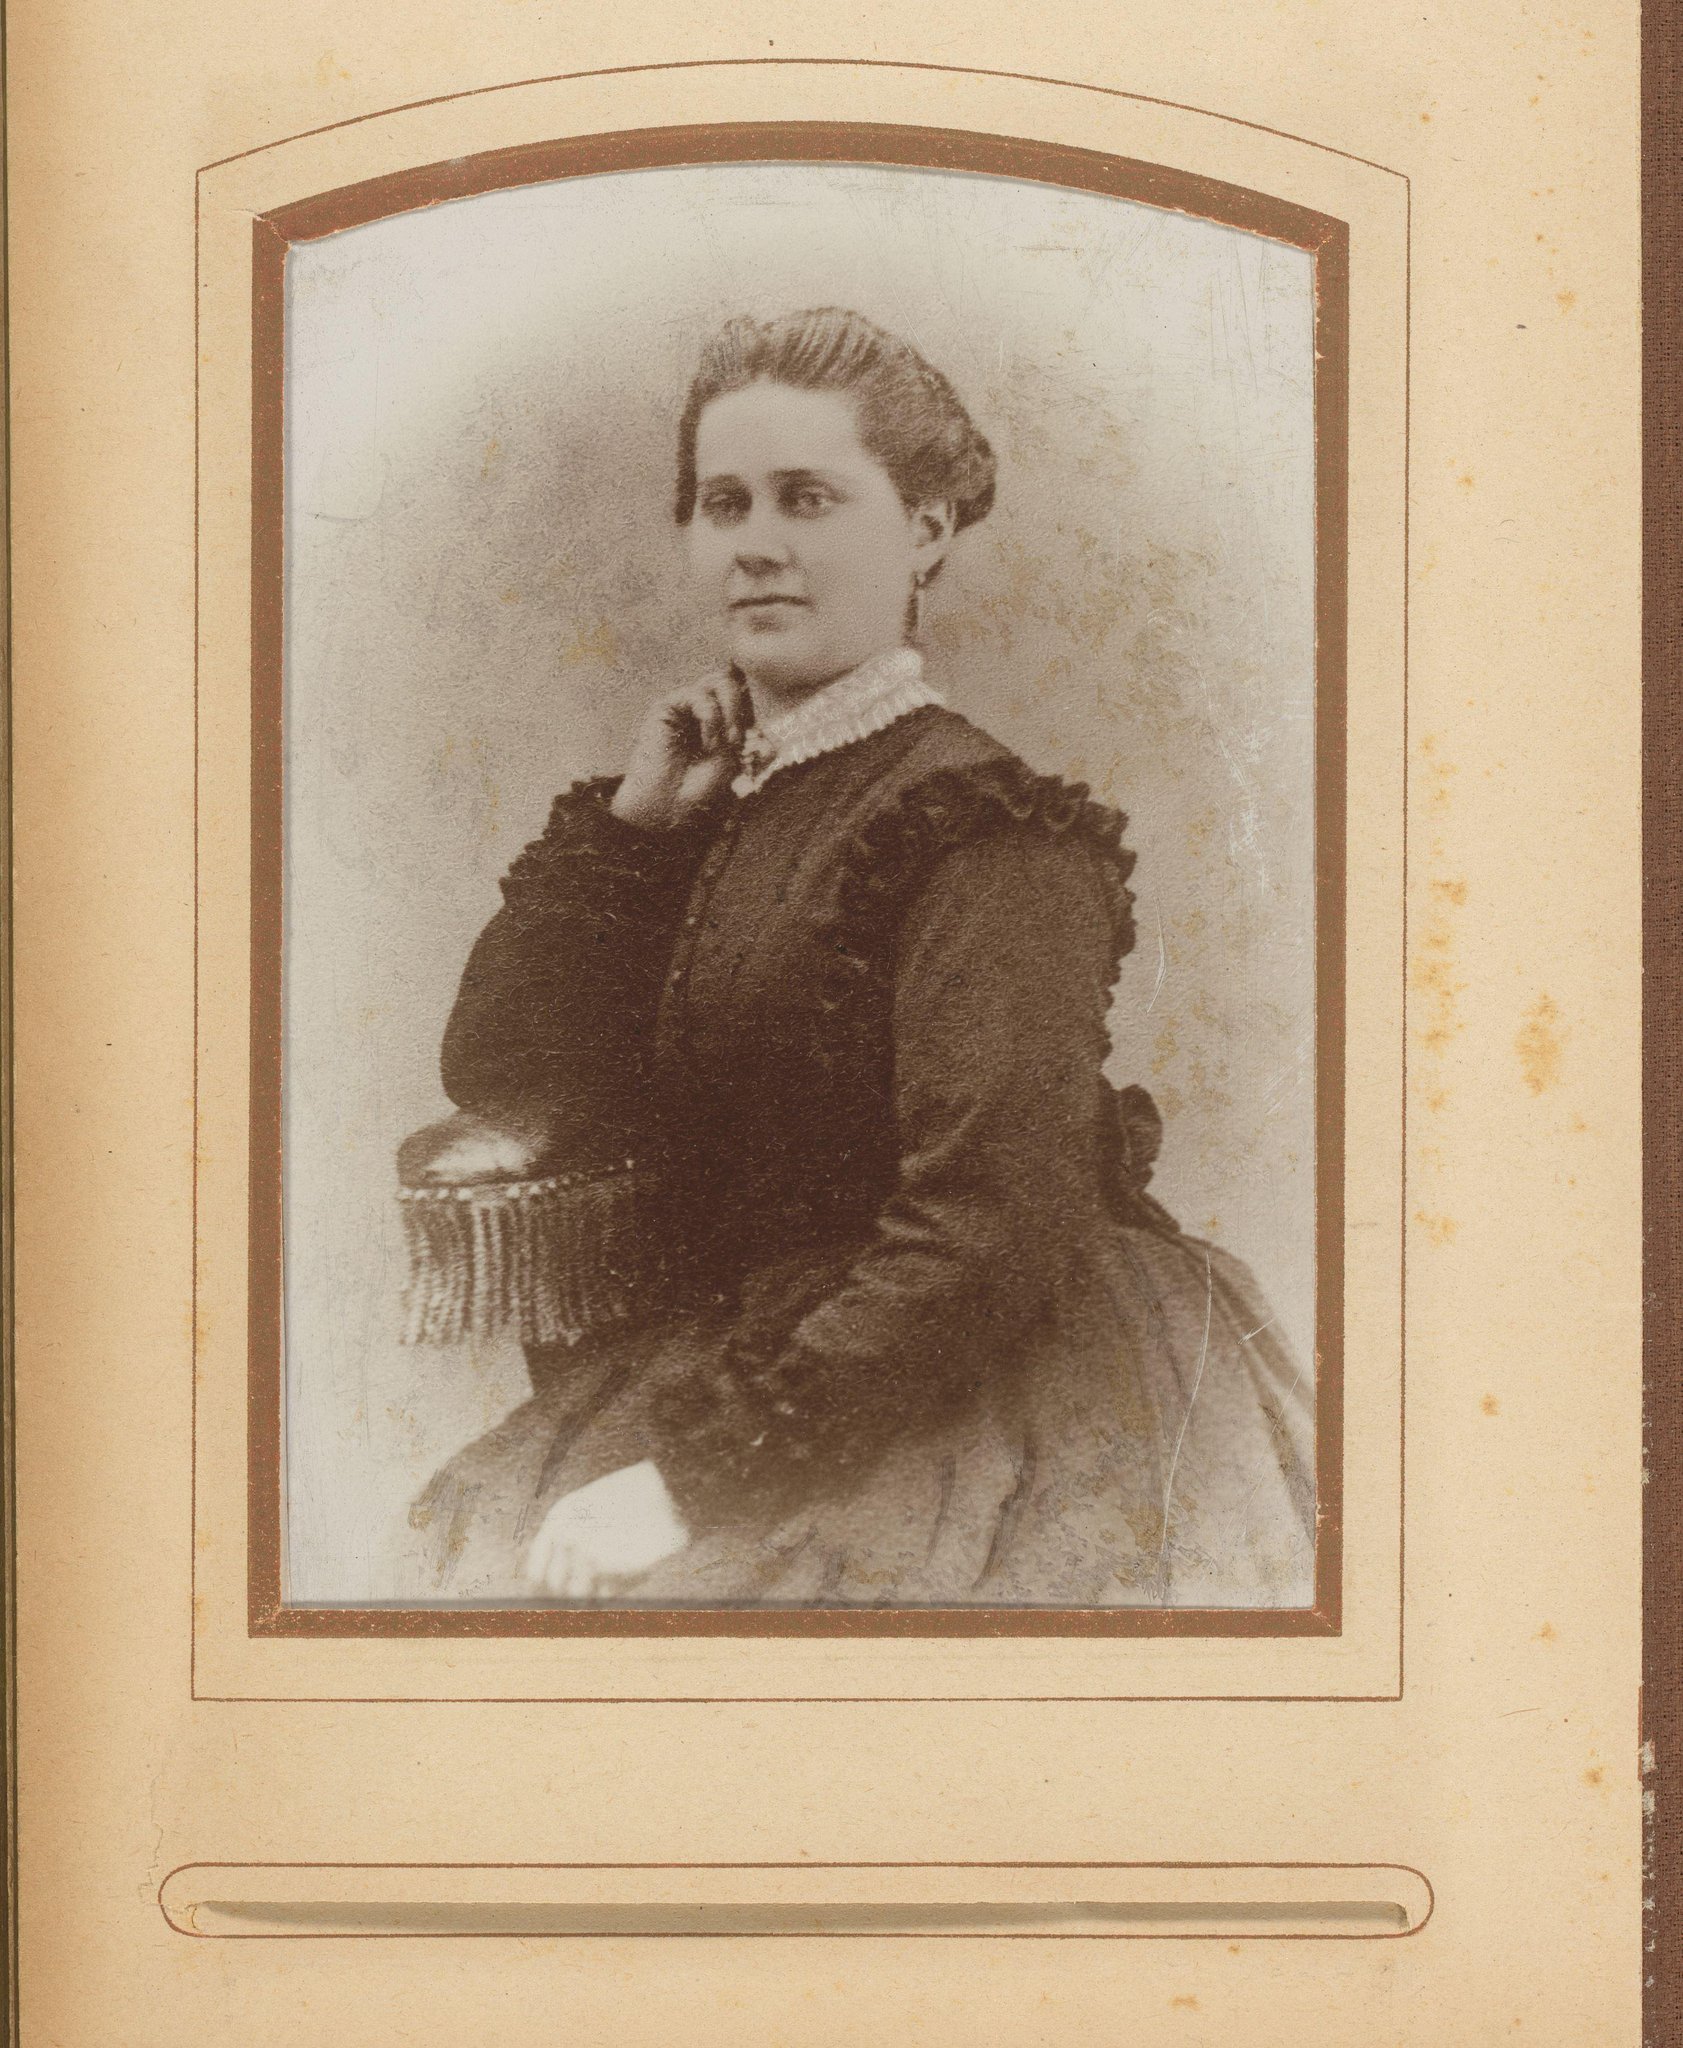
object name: photograph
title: Portret van een vrouw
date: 1881-1901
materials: cardboard, photographic support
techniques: collodion silver print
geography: haarlem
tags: historical persons - bb - woman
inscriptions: inscription: ‘C.F. & L.F. Cordes/ Haarlem’, annotation: ‘[Jon]’